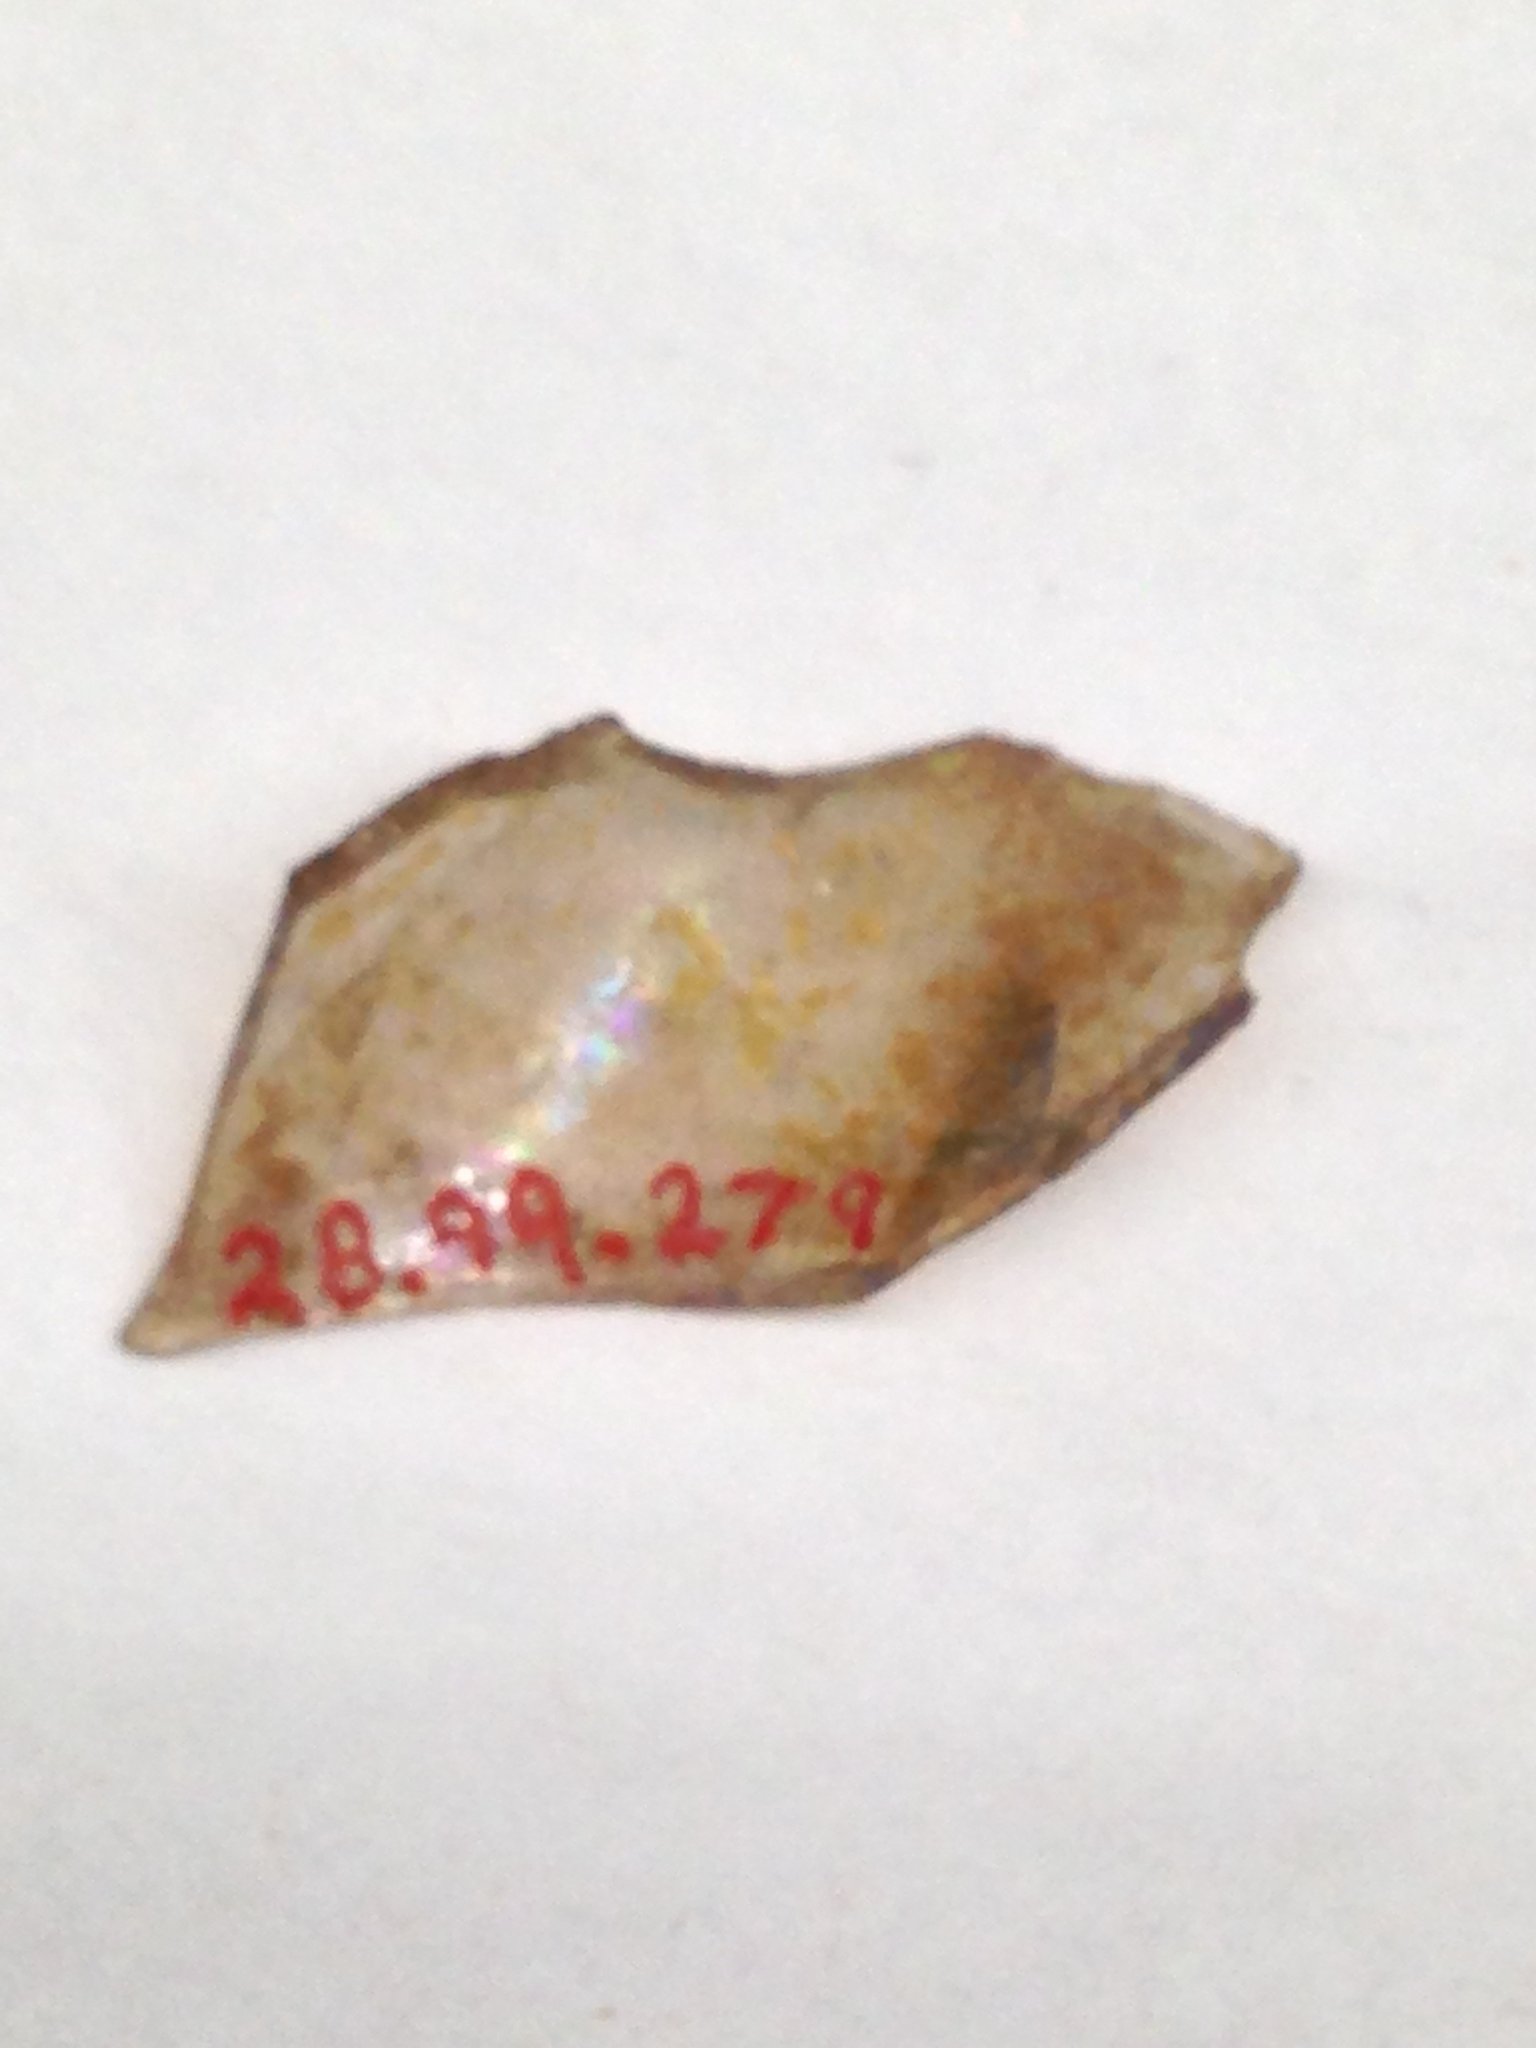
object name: fragment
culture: european or middle eastern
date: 1150-1250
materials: ceramic, glass